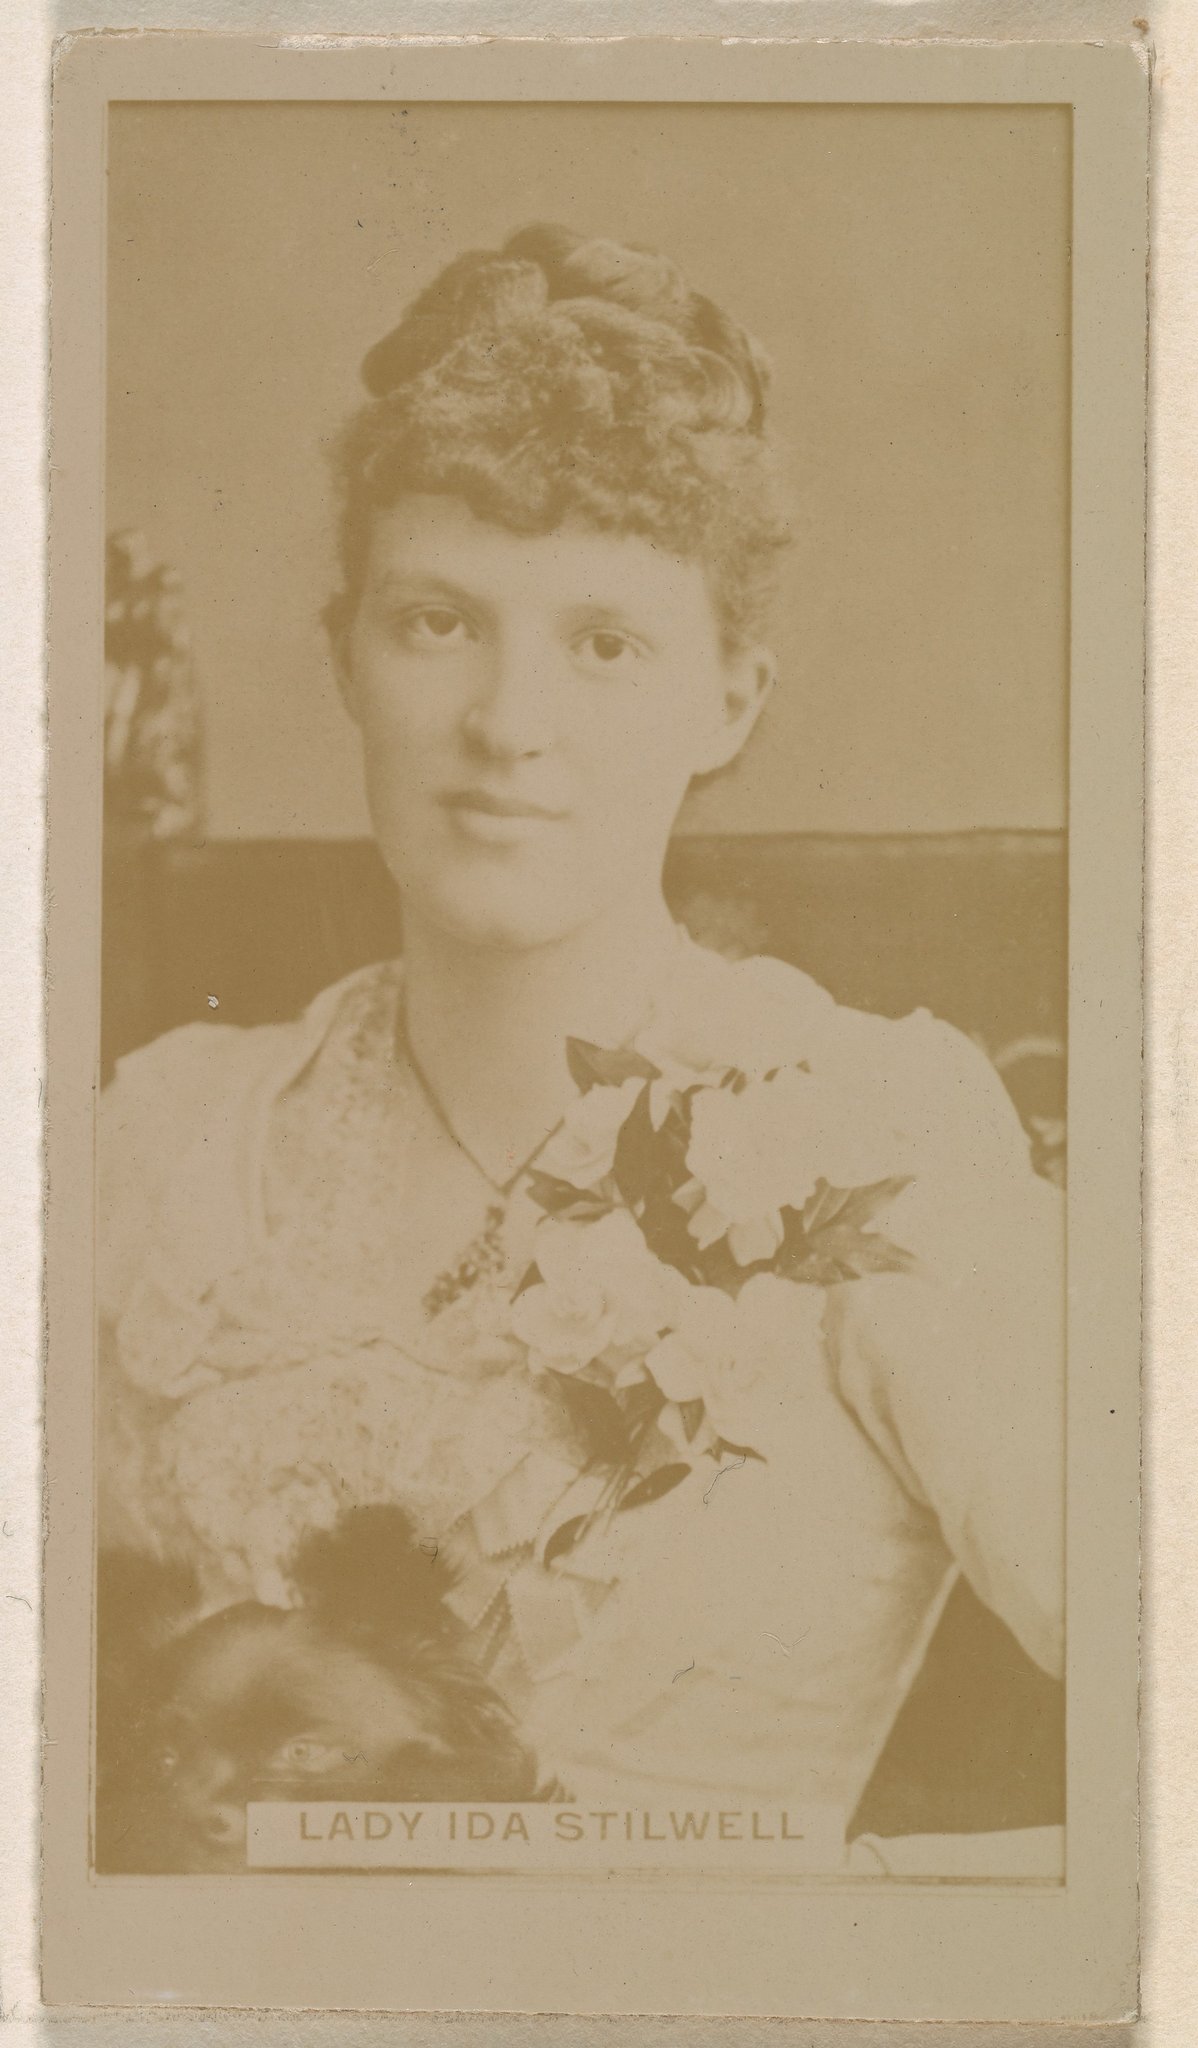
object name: photograph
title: Lady Ida Stilwell, from the Actresses series (N245) issued by Kinney Brothers to promote Sweet Caporal Cigarettes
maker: kinney brothers tobacco company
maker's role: publisher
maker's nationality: american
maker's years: 1869-2011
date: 1890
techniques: albumen silver print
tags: portraits,women,actresses